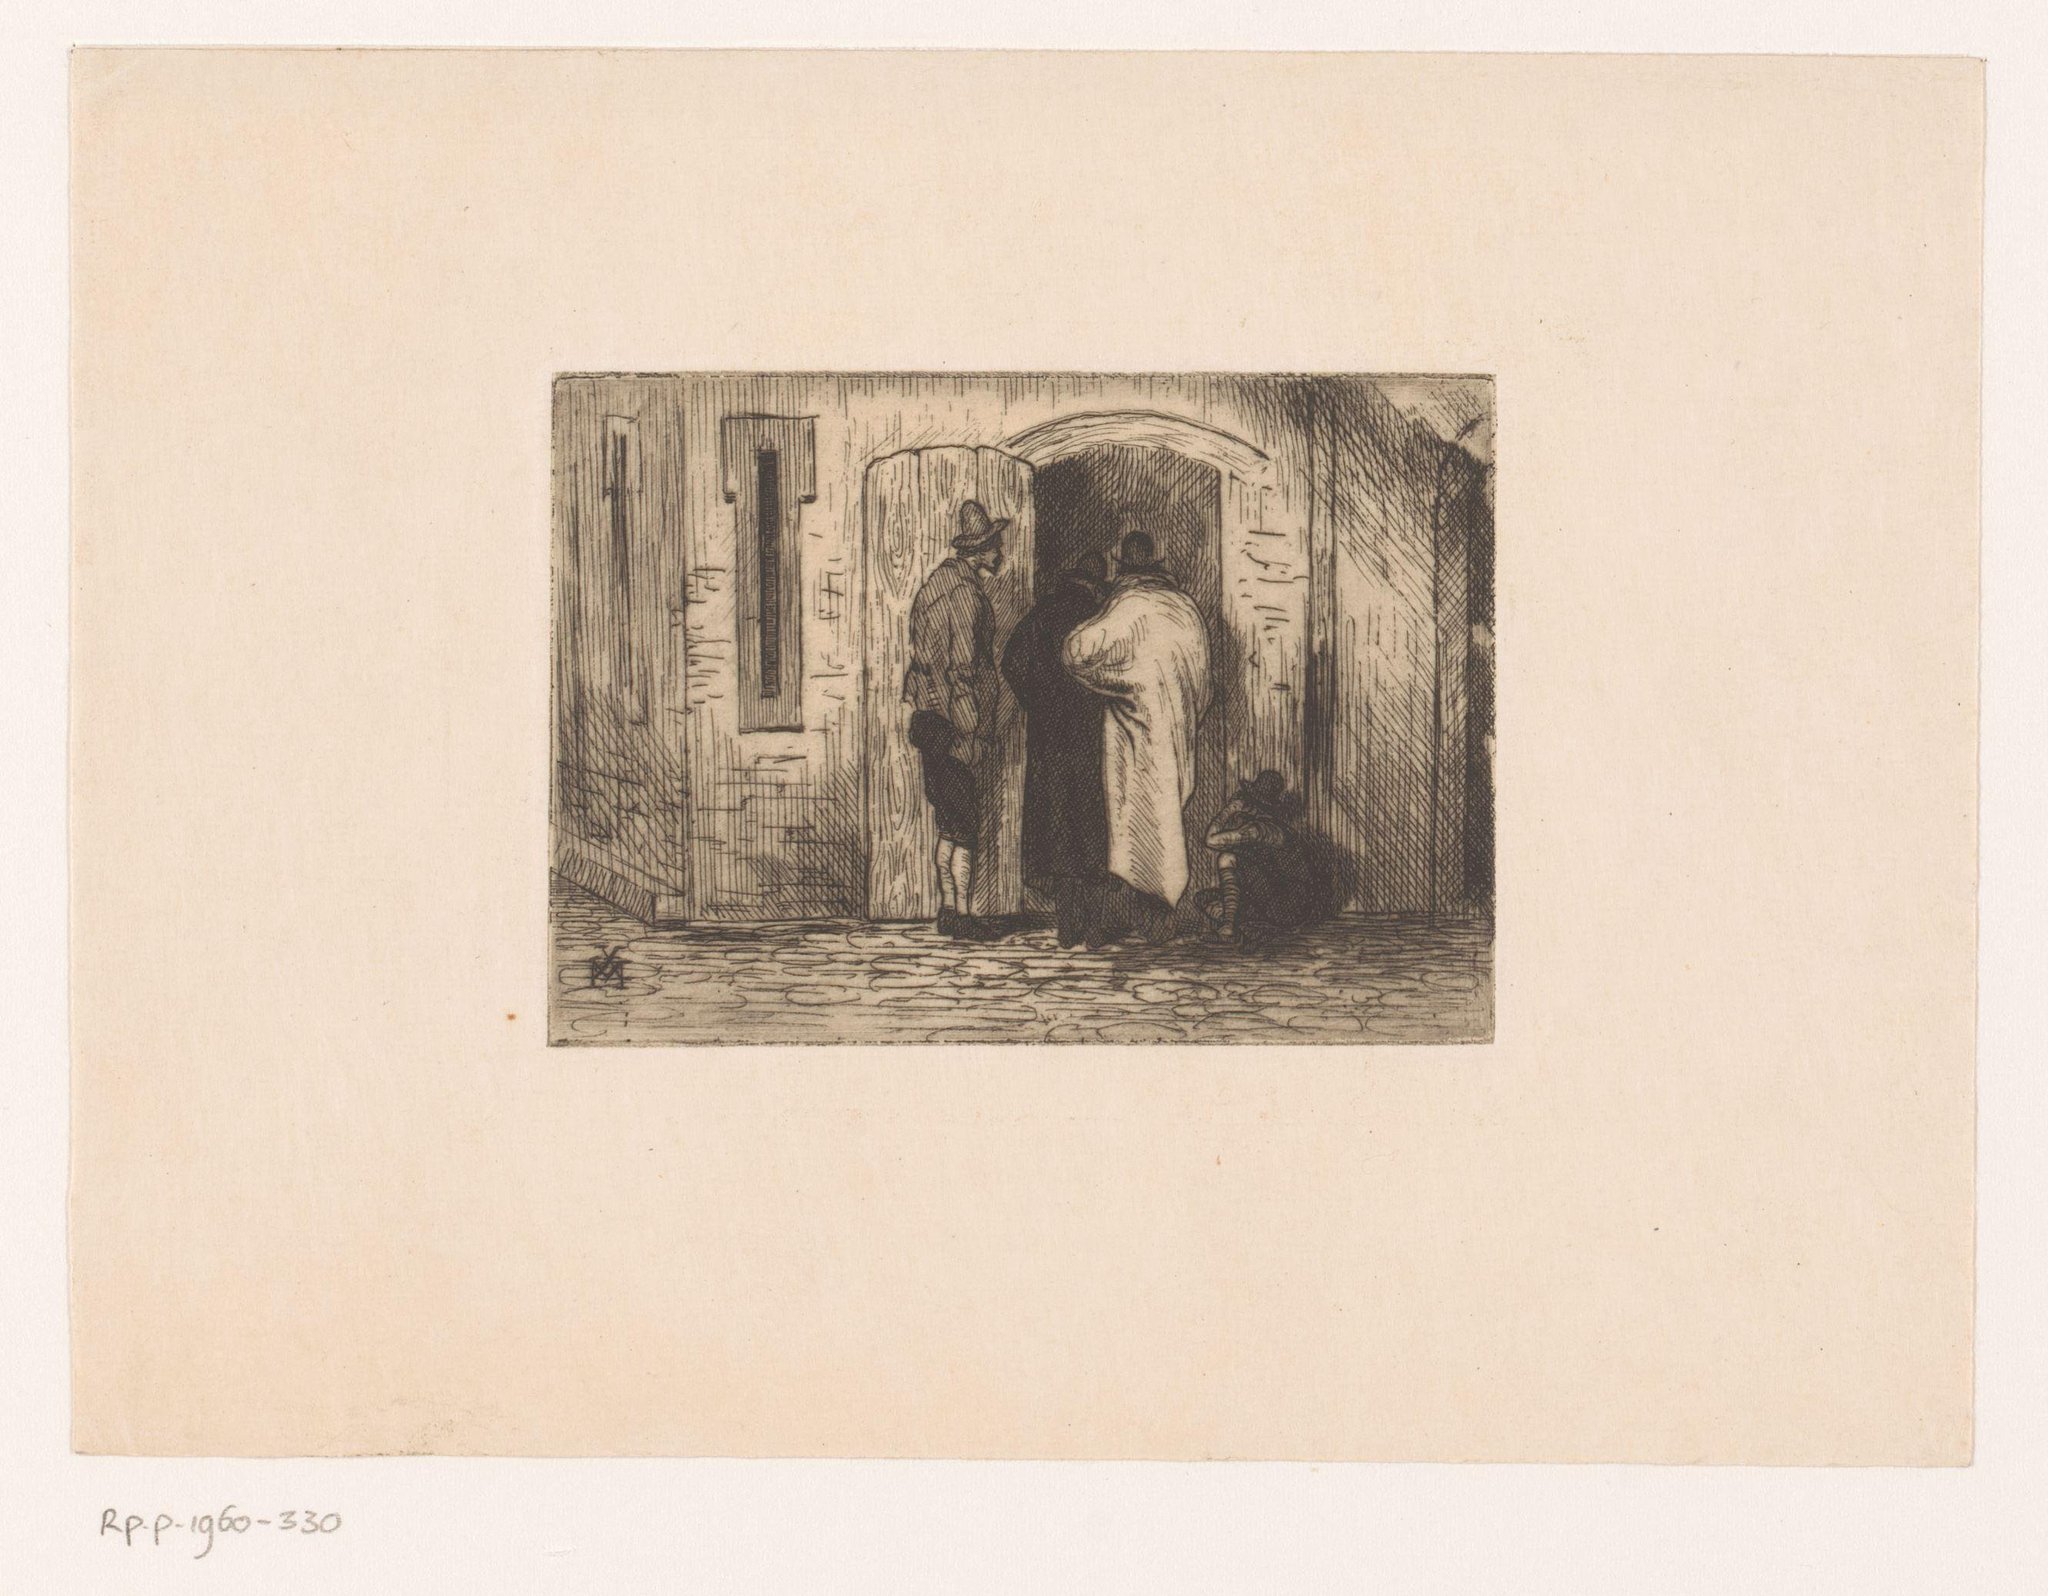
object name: print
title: Vier mannen kijken door een deuropening een gebouw binnen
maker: xavier mellery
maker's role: print maker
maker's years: 1845-1921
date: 1855-1913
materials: paper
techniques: etching, intaglio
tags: open door, adult man (+ four persons), street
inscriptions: collector's mark: Lugt 2228